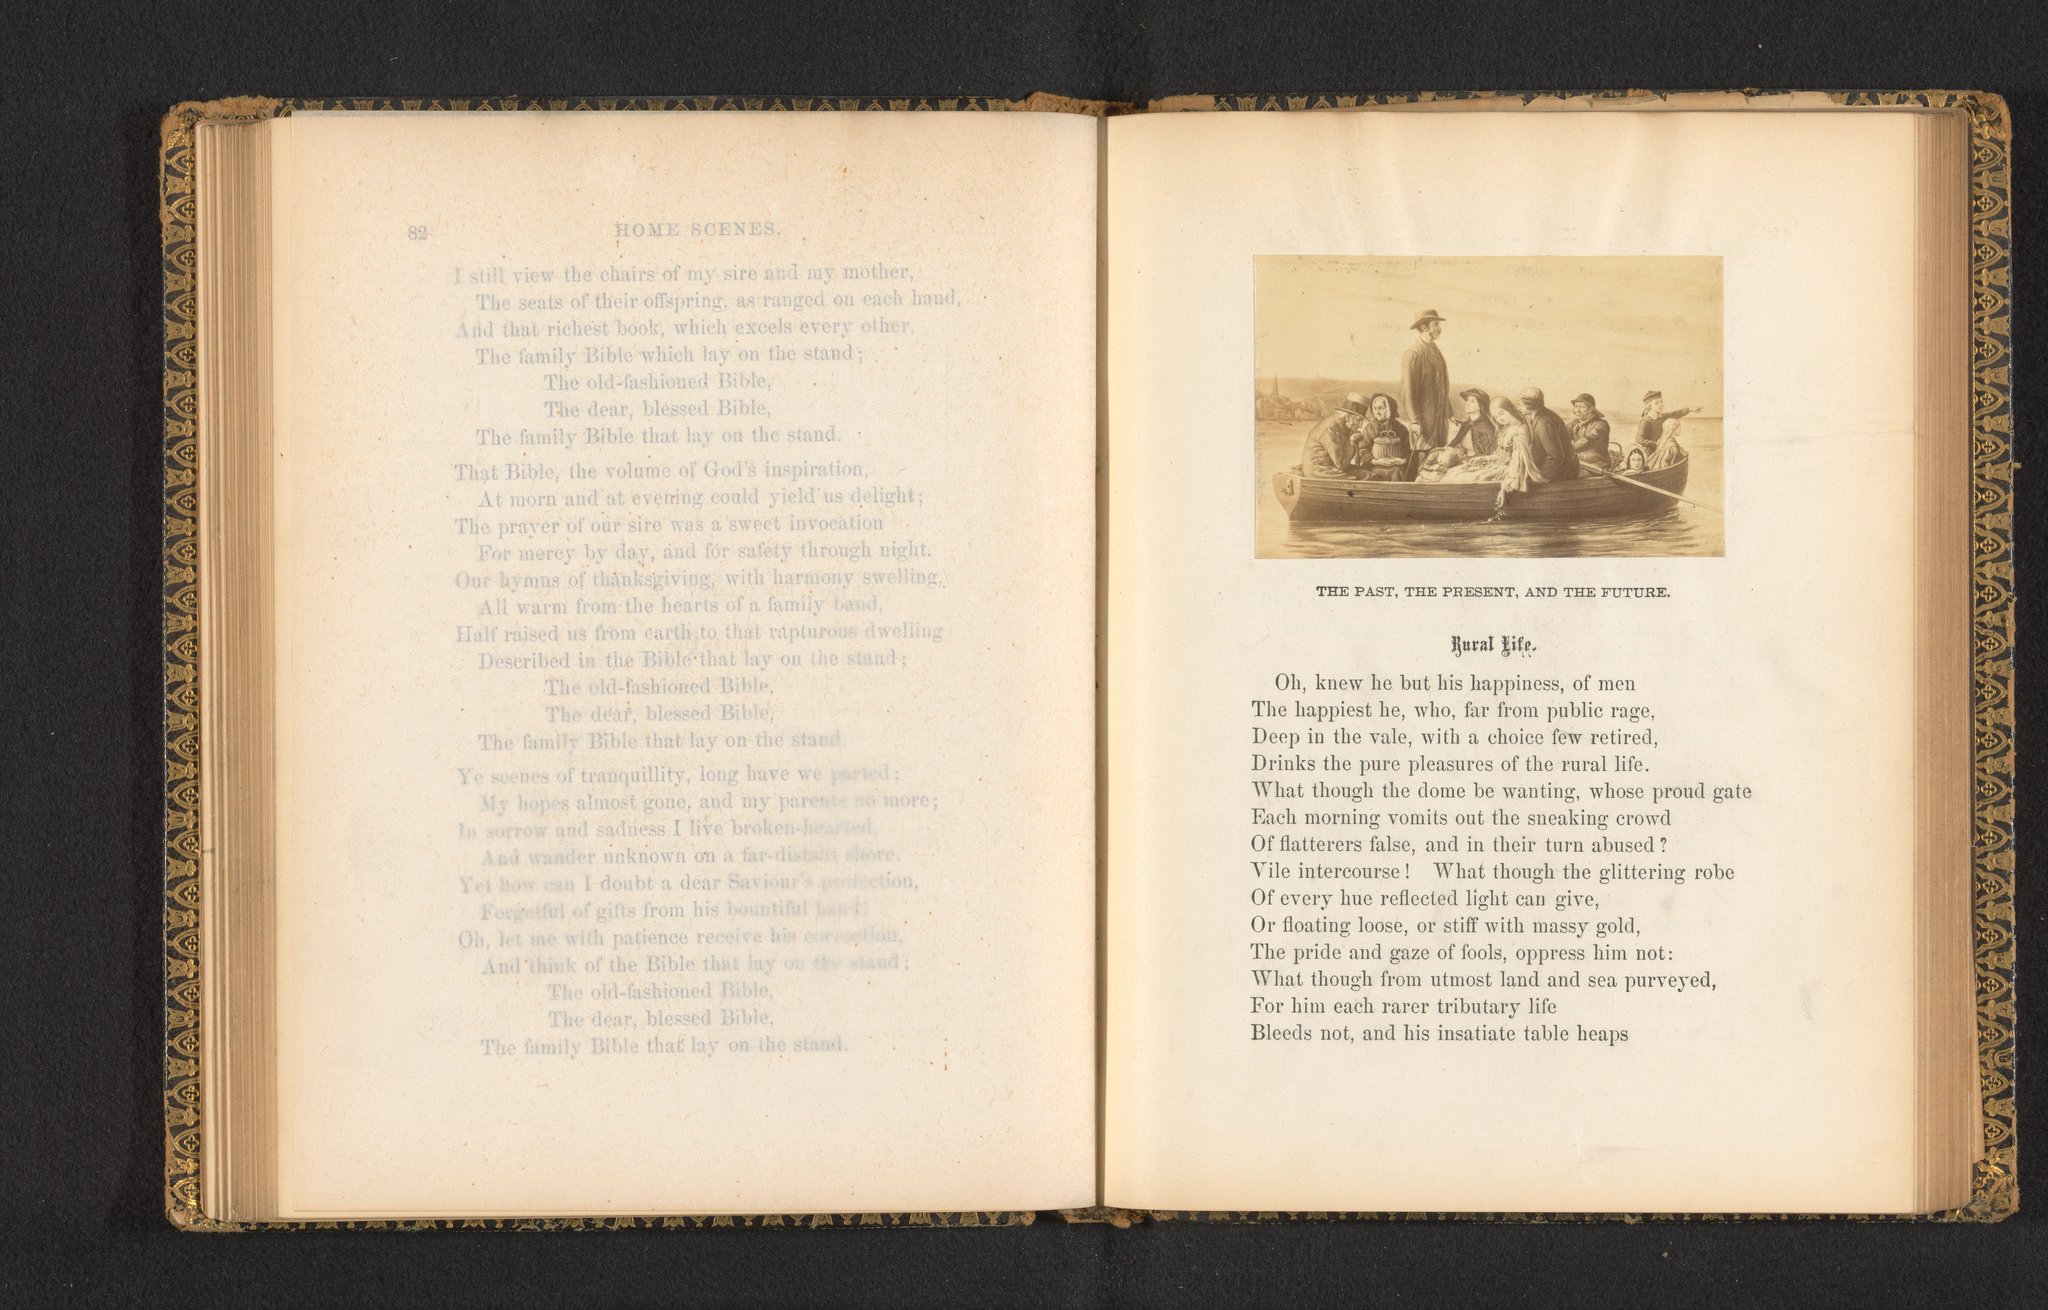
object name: photograph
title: Rural life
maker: Anonymous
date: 1860-1865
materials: photographic support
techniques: albumen print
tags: rowing-boat, canoe, etc.